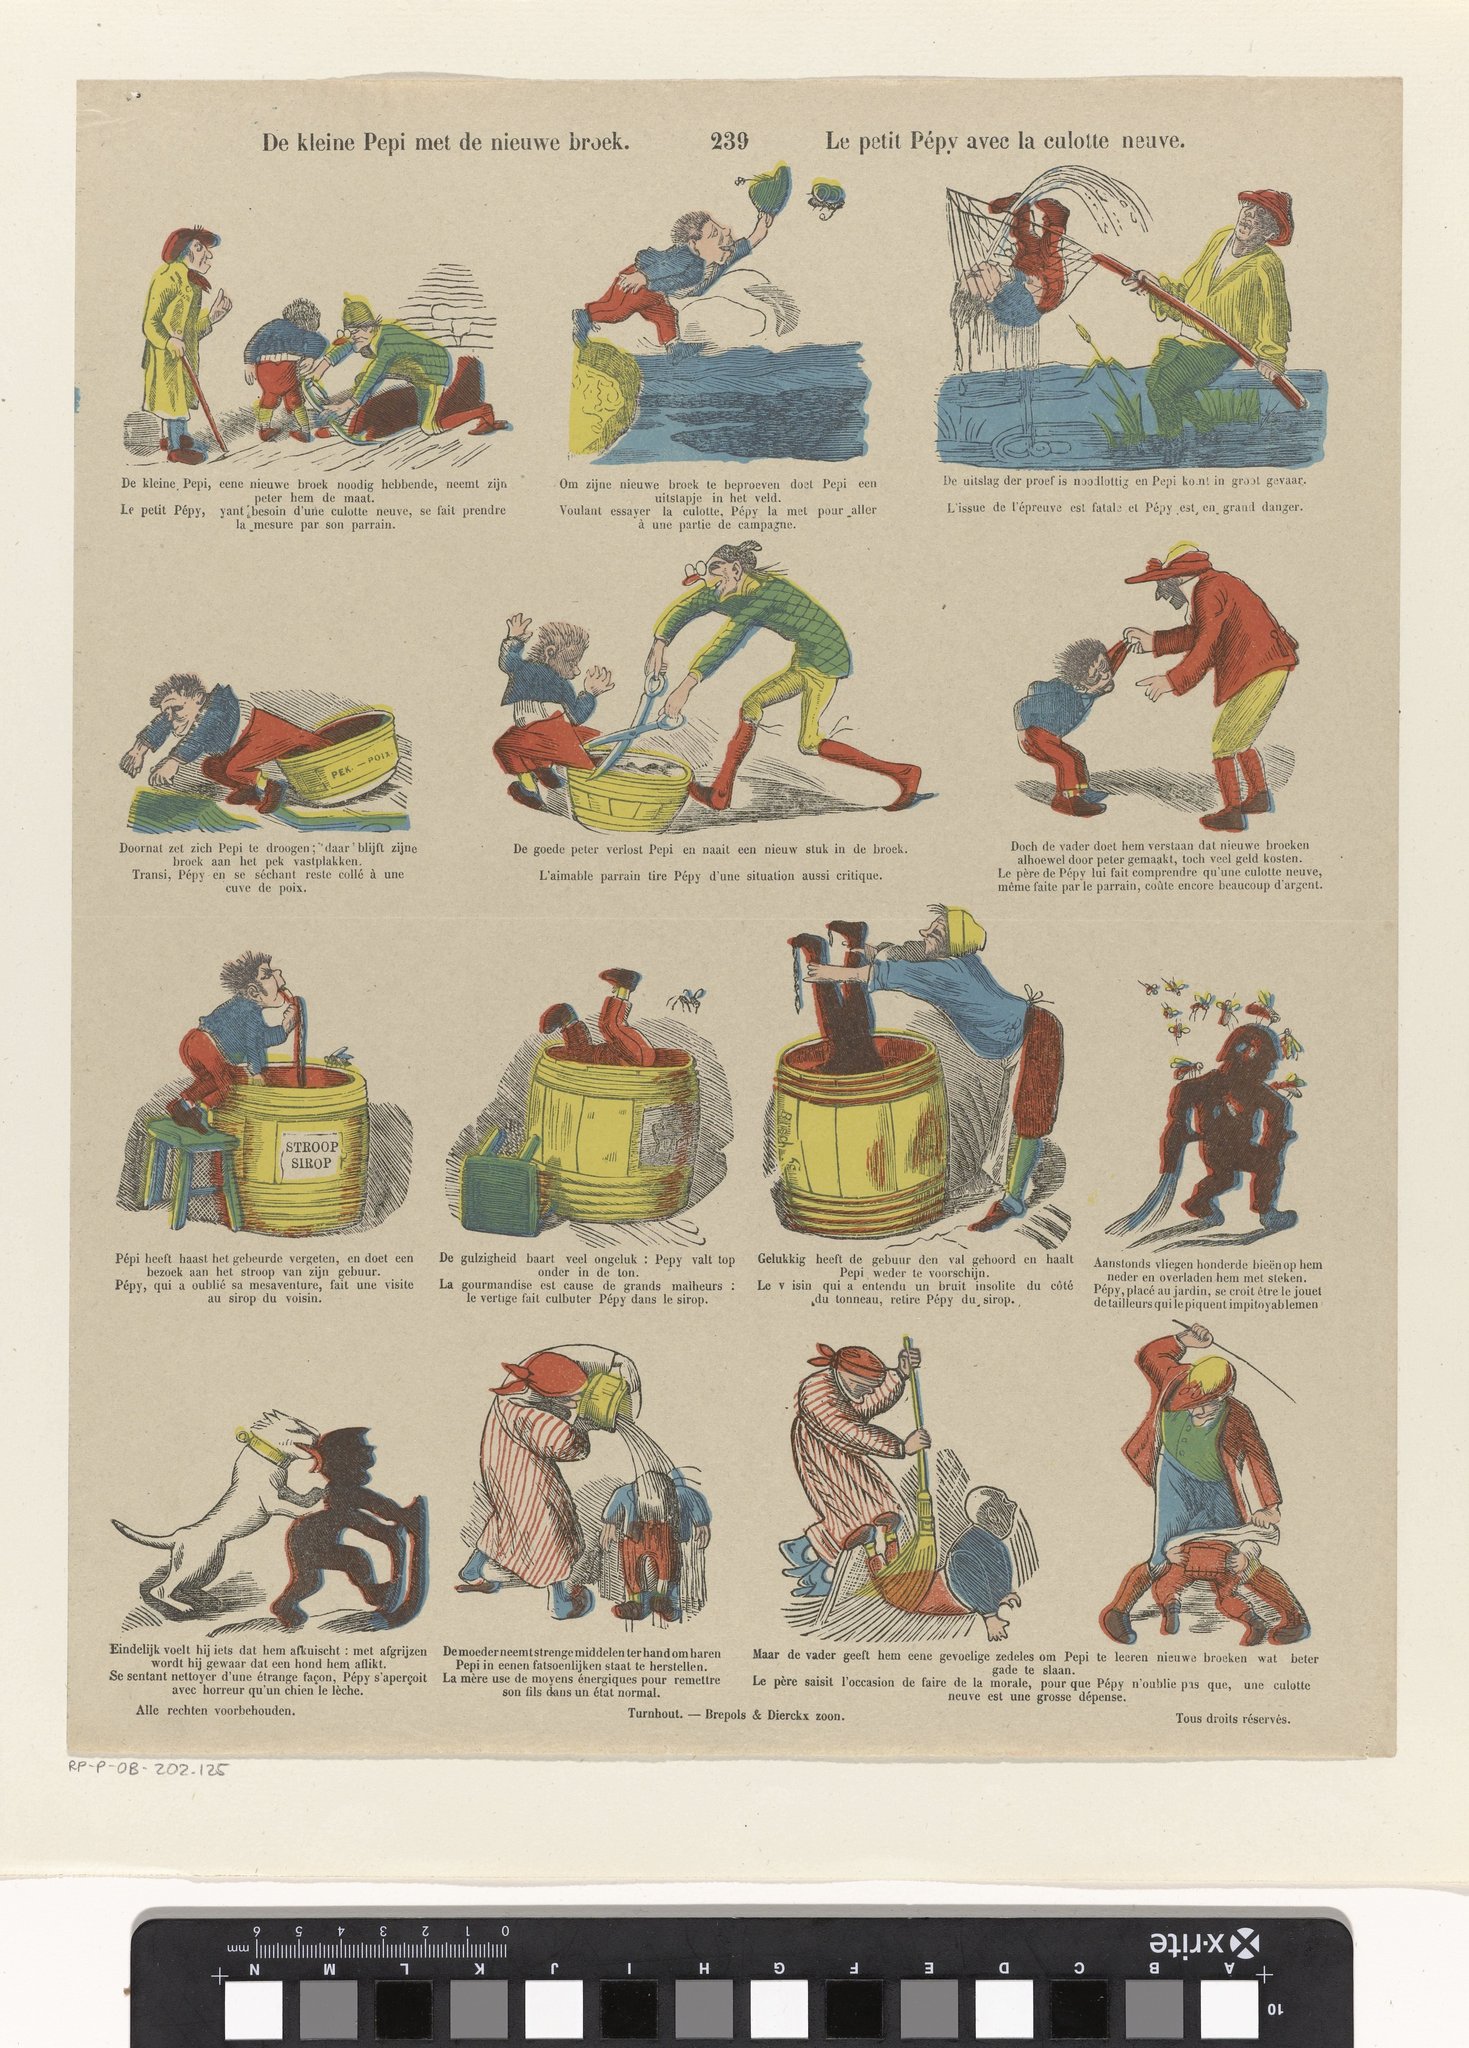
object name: popular print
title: De kleine Pepi met de nieuwe broek / Le petit Pépy avec la culotte neuve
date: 1833-1911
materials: paper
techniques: lithograph, letterpress printing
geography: turnhout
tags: mischief-making play, correction of naughty children, trousers, breeches, bad behaviour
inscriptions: collector's mark: Lugt 2760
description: Blad met 14 voorstellingen over Pepi die met zijn nieuwe broek allerlei kattenkwaad uithaalt en een pak slaag krijgt. Onder elke afbeelding een onderschrift in het Nederlands en in het Frans. Genummerd midden boven: 239.